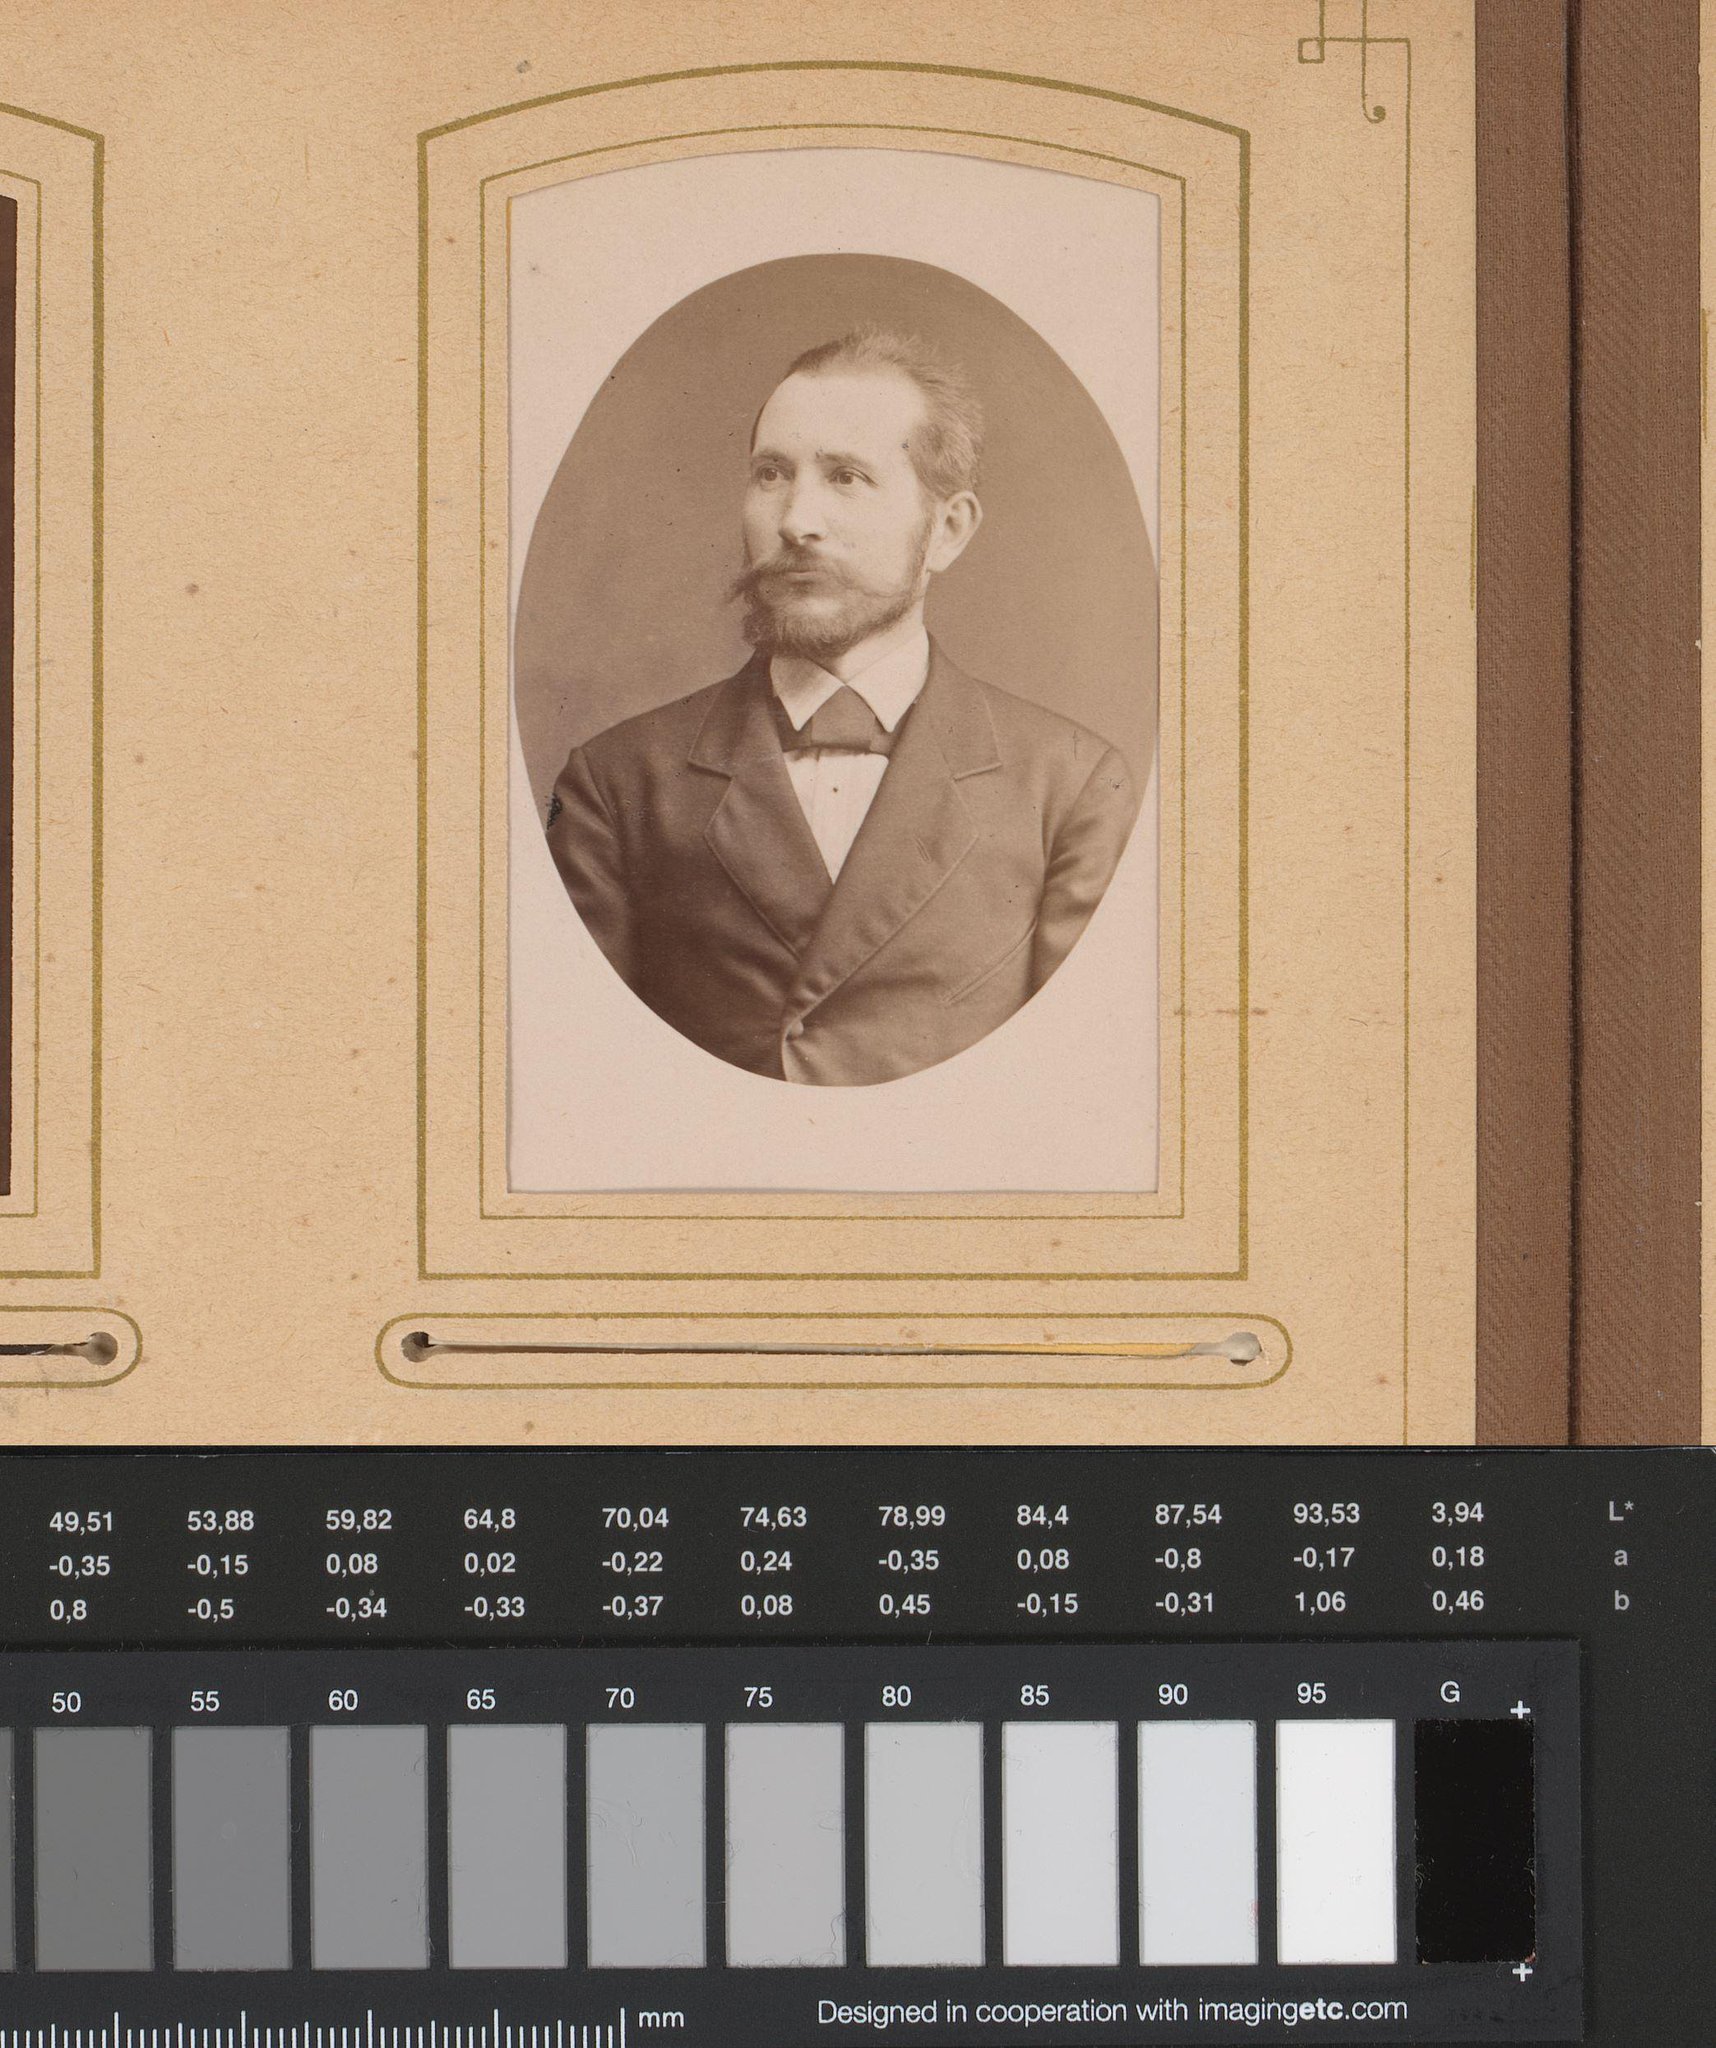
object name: cabinet photograph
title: Portret van een man met snor en baard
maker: ernst schroeter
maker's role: fotograaf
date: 1860-1900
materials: cardboard, photographic support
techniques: albumen print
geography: meissen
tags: moustache, historical persons, beard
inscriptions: inscription: ‘Ernst Schroeter/ Meissen/ 597, Obergasse 597.’